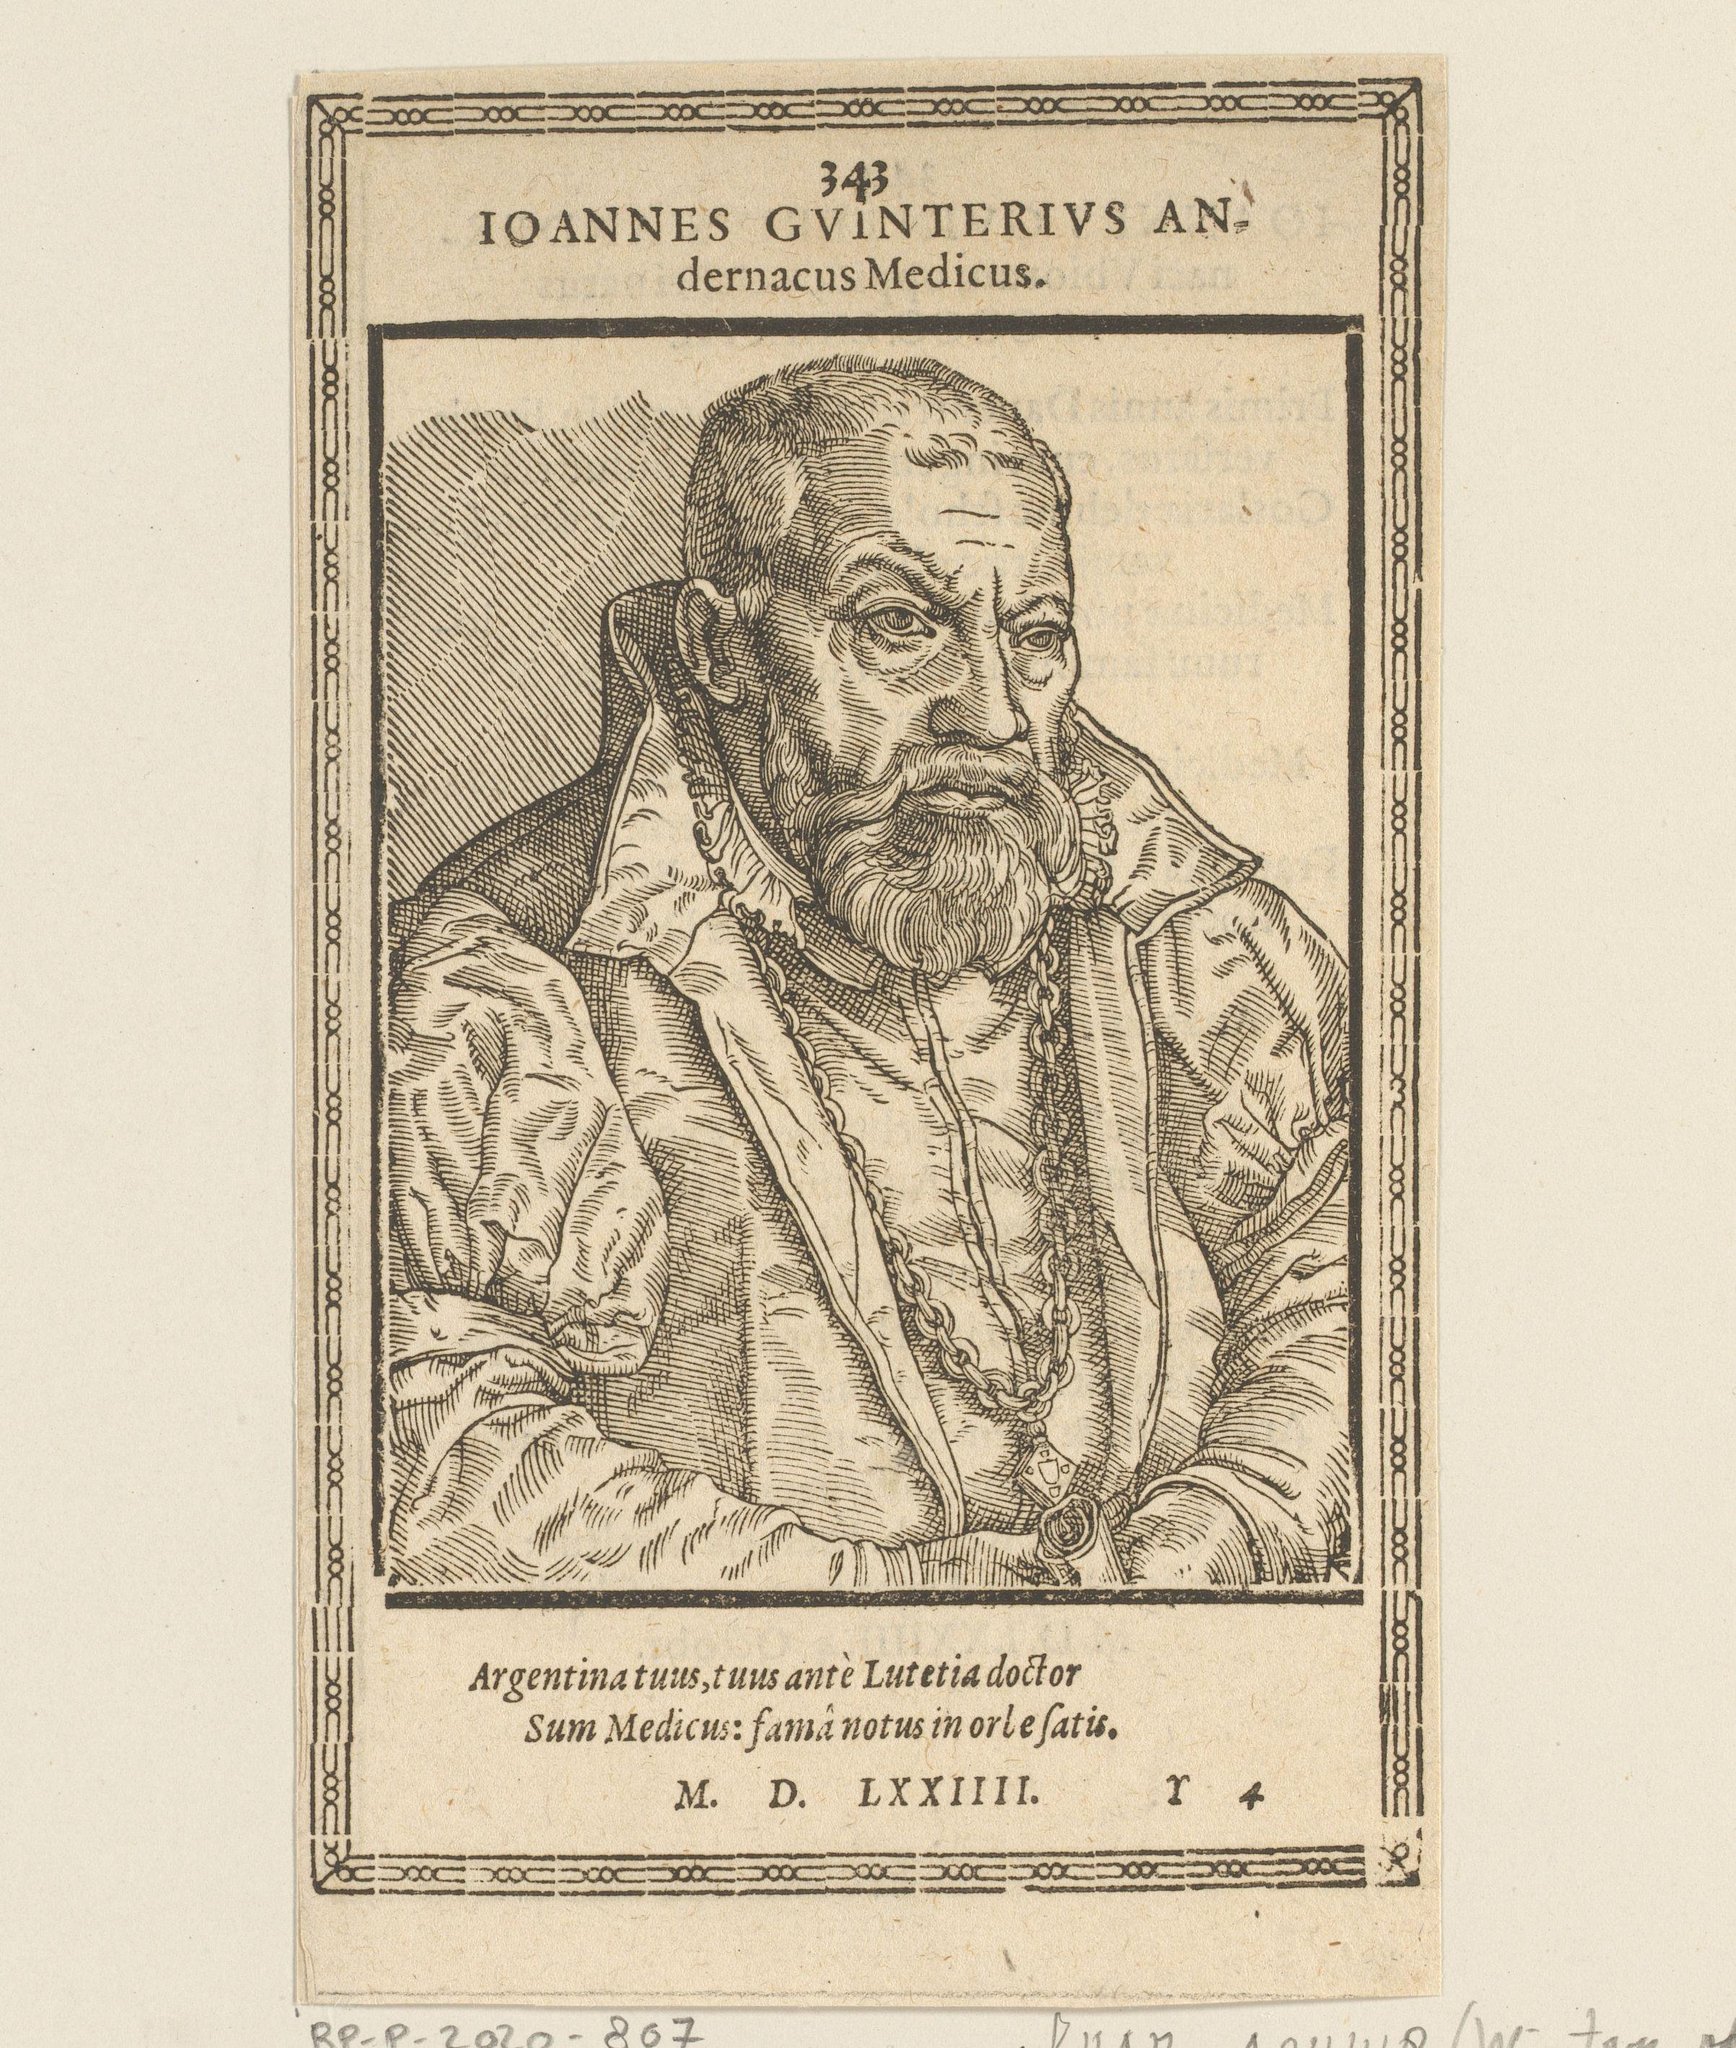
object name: book illustration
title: Portret van Johann Winter von Andernach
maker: bernhard jobin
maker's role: printer, publisher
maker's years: 1545-1593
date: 1590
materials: paper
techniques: letterpress printing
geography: straatsburg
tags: historical persons, physician, doctor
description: Prent uit: Reusner, Nikolaus. Icones sive imagines virorum literis illustrium (...). Straatsburg: Bernhard Jobin, 1590, p. 343. Prent voor het eerst verschenen in de eerste editie van 1587. Prent ook gebruikt in latere publicaties.